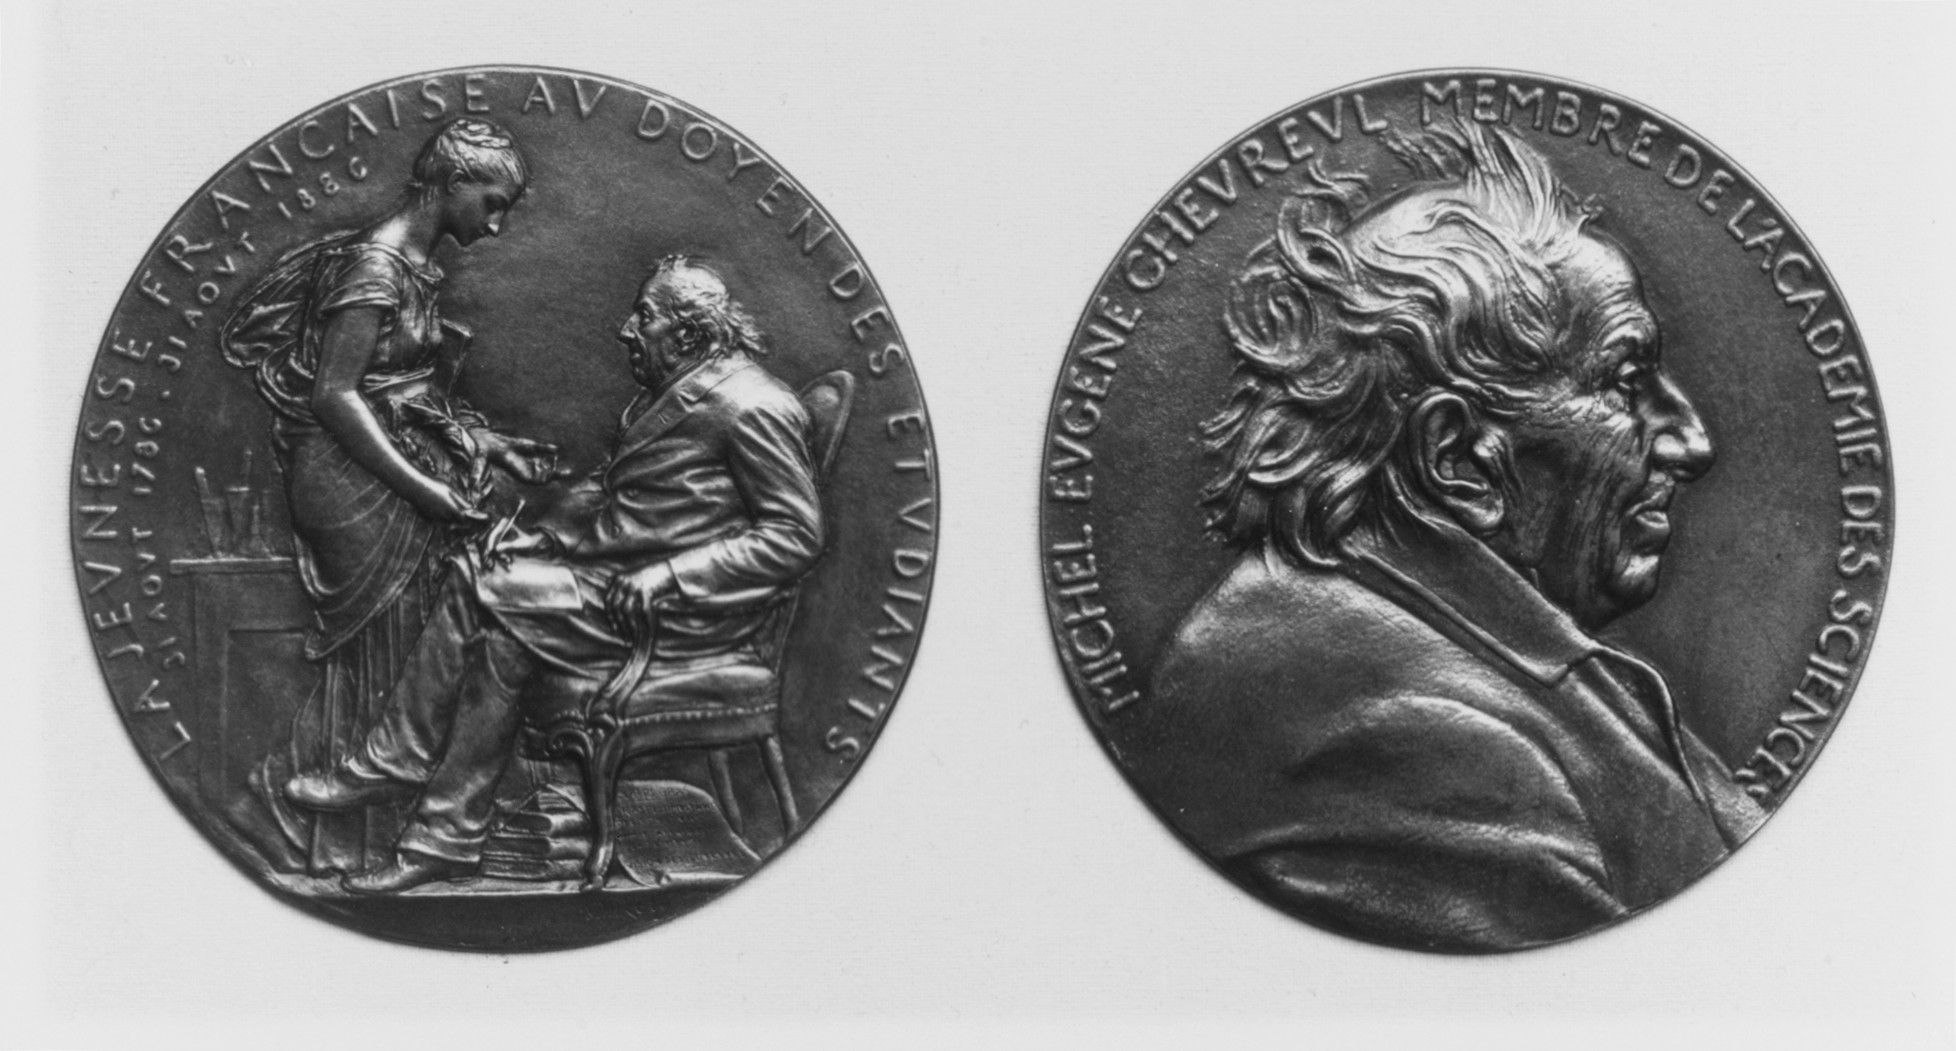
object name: uniface medal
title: Commemorating the 100th Birthday of M. Michel Eugène Chevreul (1786–1889), French Chemist and Member of the Academy of Sciences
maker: louis-oscar roty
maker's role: artist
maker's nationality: french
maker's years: 1846-1911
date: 1886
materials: bronze, patina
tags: men,profiles,women